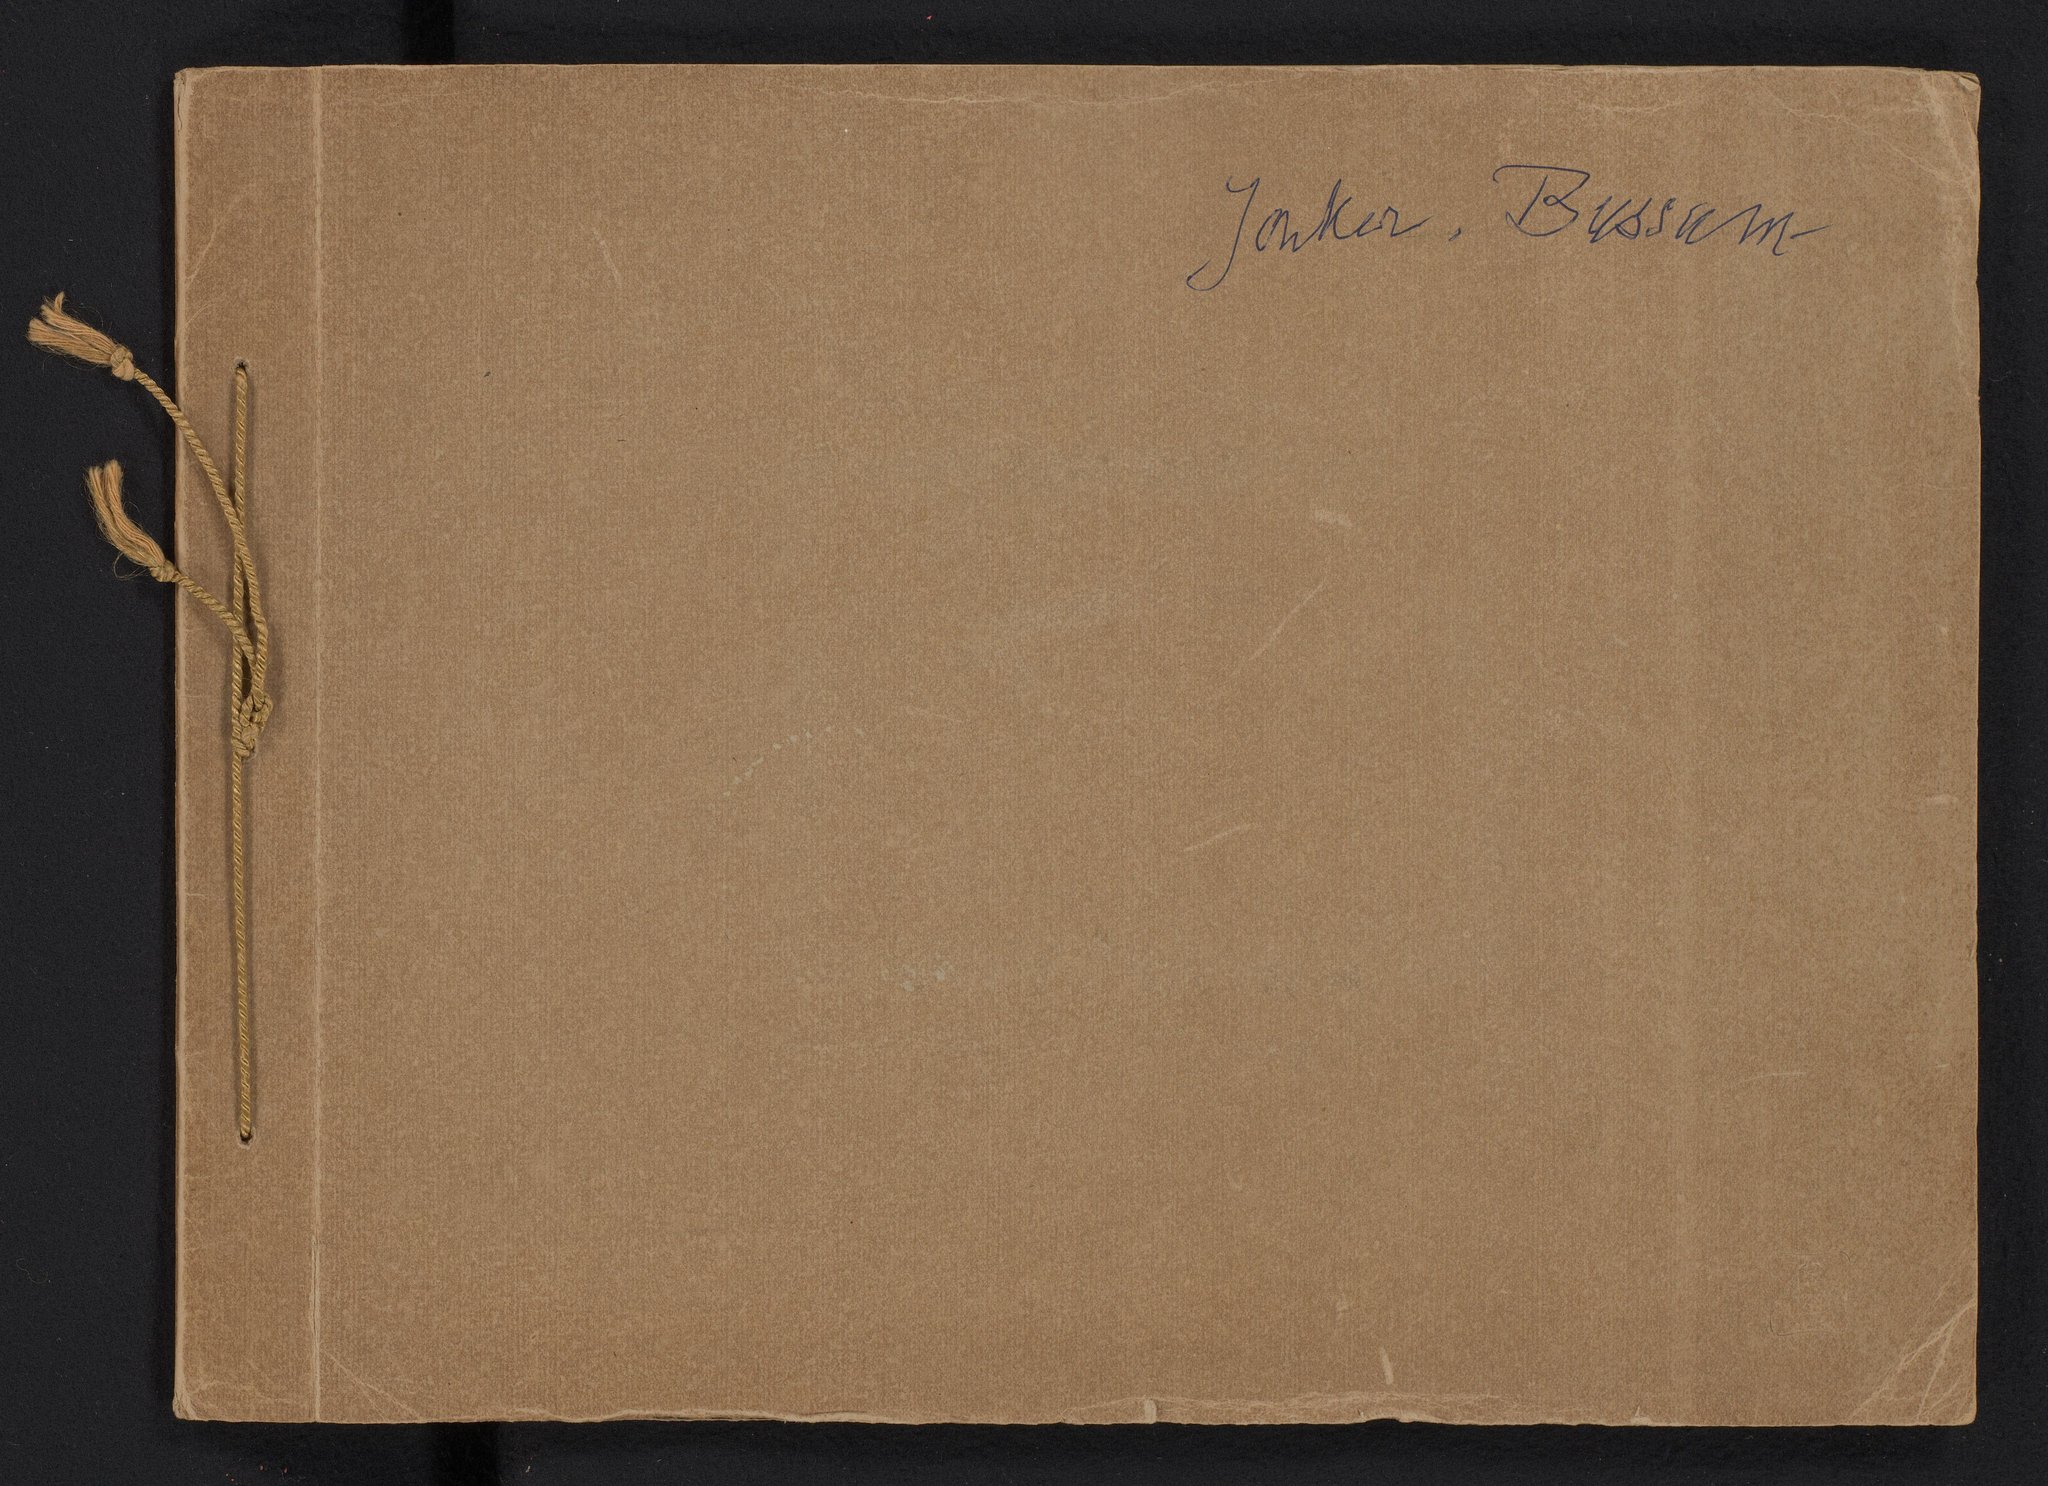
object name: scrapbook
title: Fotoalbum van het huis en gezin van Lucas Jonker in Bussum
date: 1890-1915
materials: paper, textile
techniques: gelatin silver print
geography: bussum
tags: adult man, interior of the house, family life at home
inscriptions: inscription: ‘Jonker, Bussum’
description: Plakboek met negen foto's op acht bladen, zonder bijschriften. De foto's zijn gemaakt in de huiselijke kring van de familie van Lucas Jonker te Bussum, waarschijnlijk door een professionele fotograaf van Fotografisch Atelier Brinklaan. Een van de foto's, een portret van Jonker gemaakt door Koene & Büttinghausen, bevindt zich los in het album.